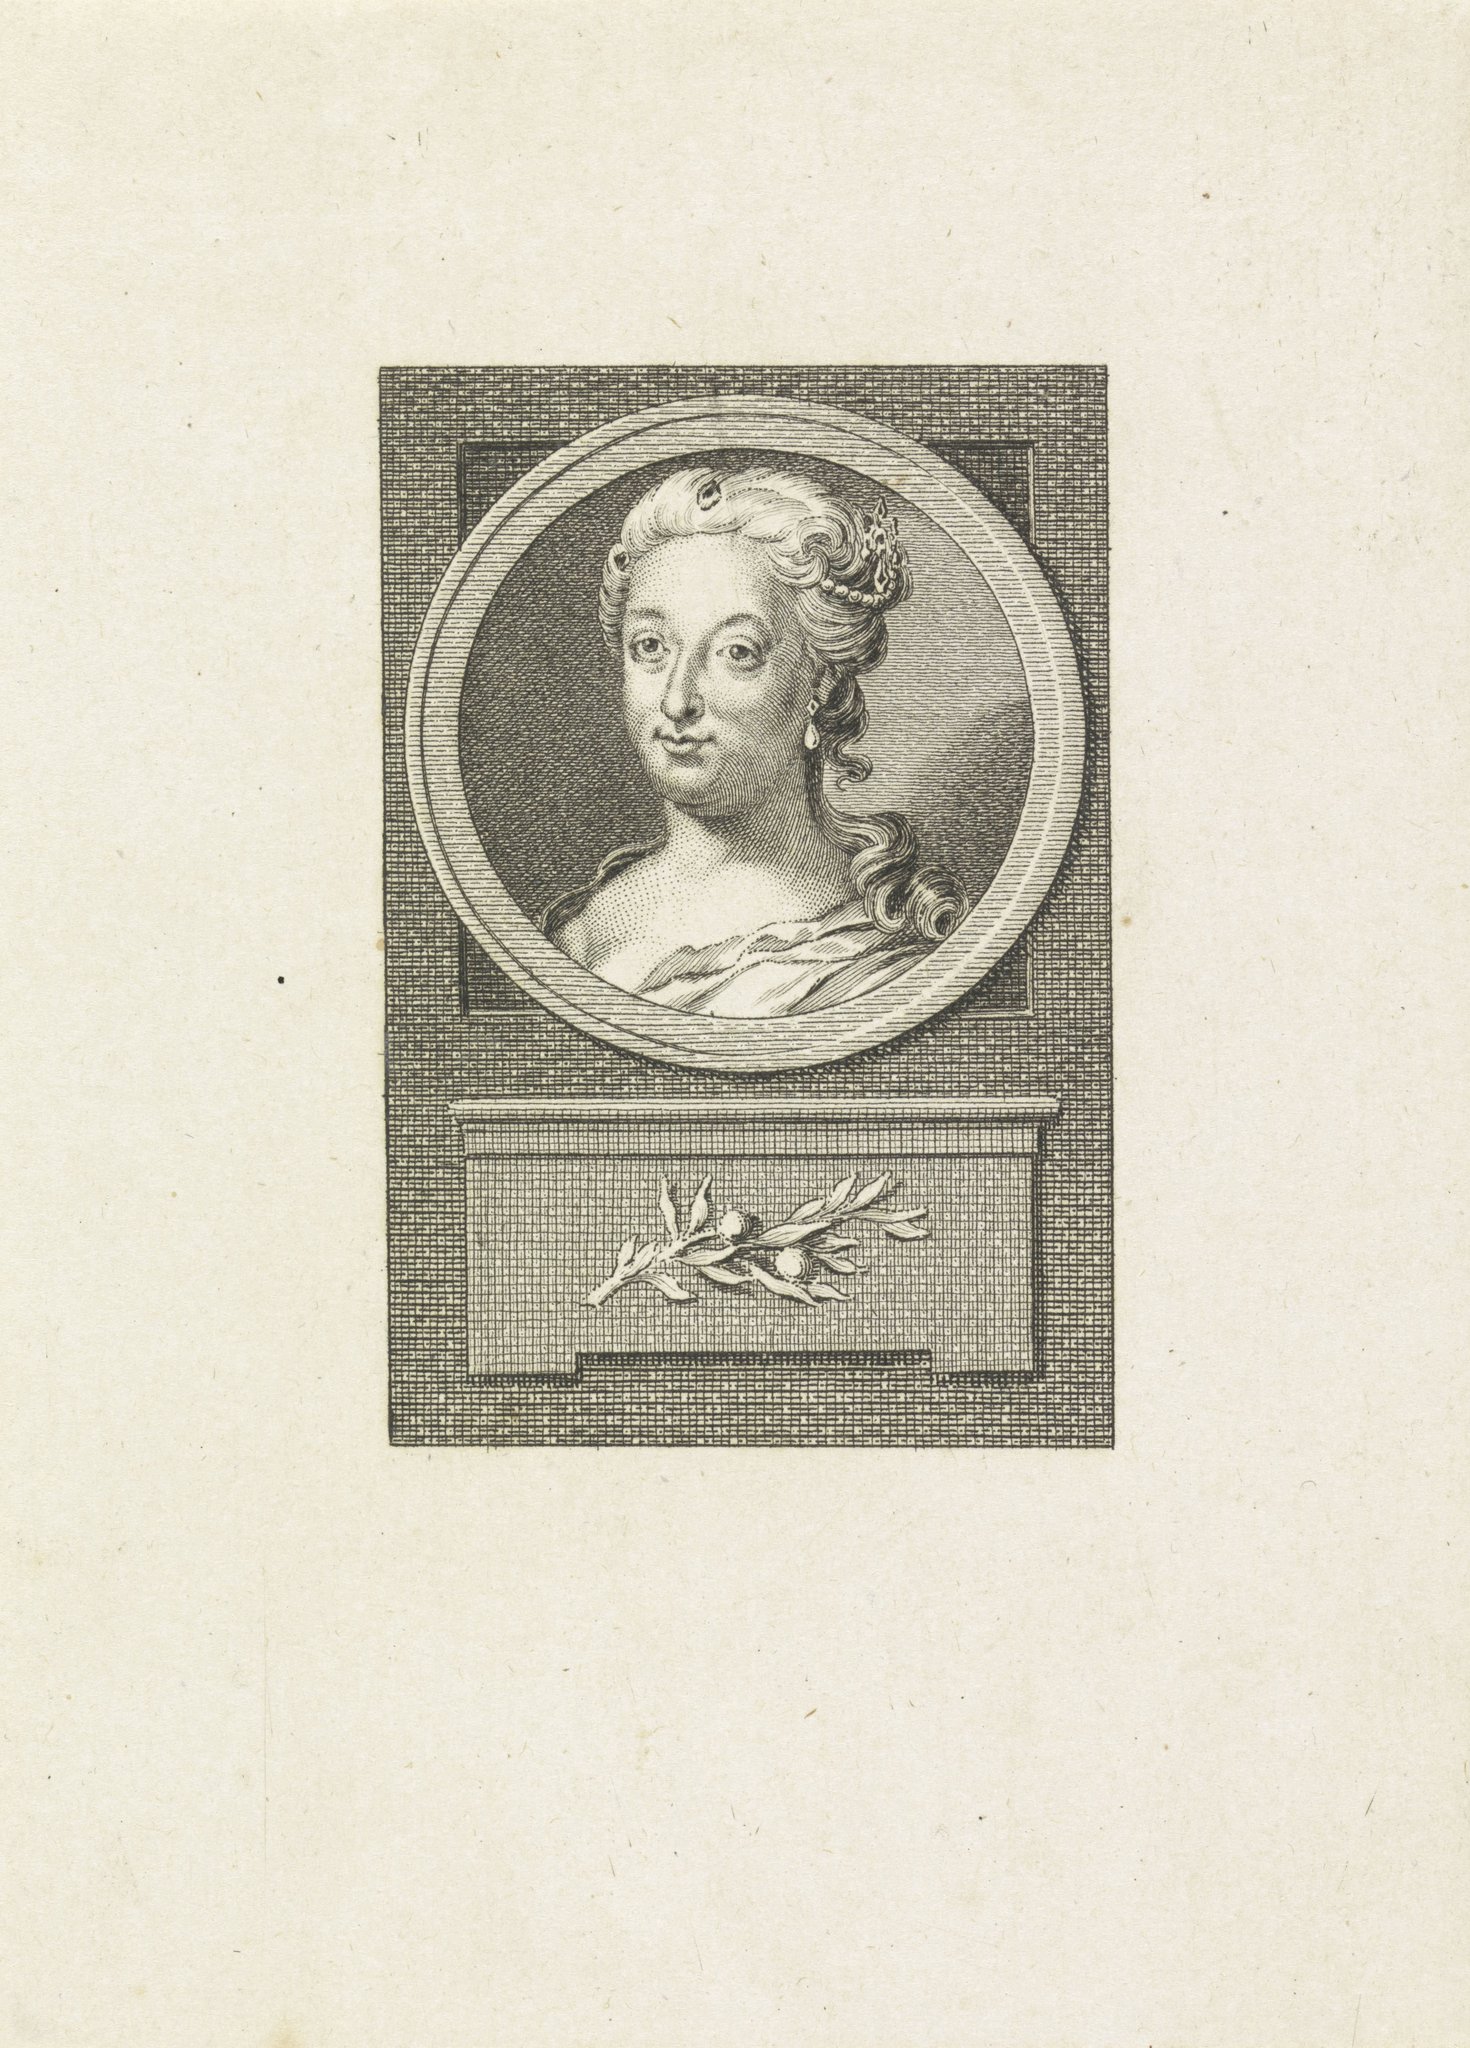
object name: print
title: Portret van Anna van Hannover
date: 1771-1816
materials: paper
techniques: engraving, etching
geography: amsterdam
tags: anna van hannover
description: Portret van Anna in een cirkel. Op een voetstuk een oranjetak.